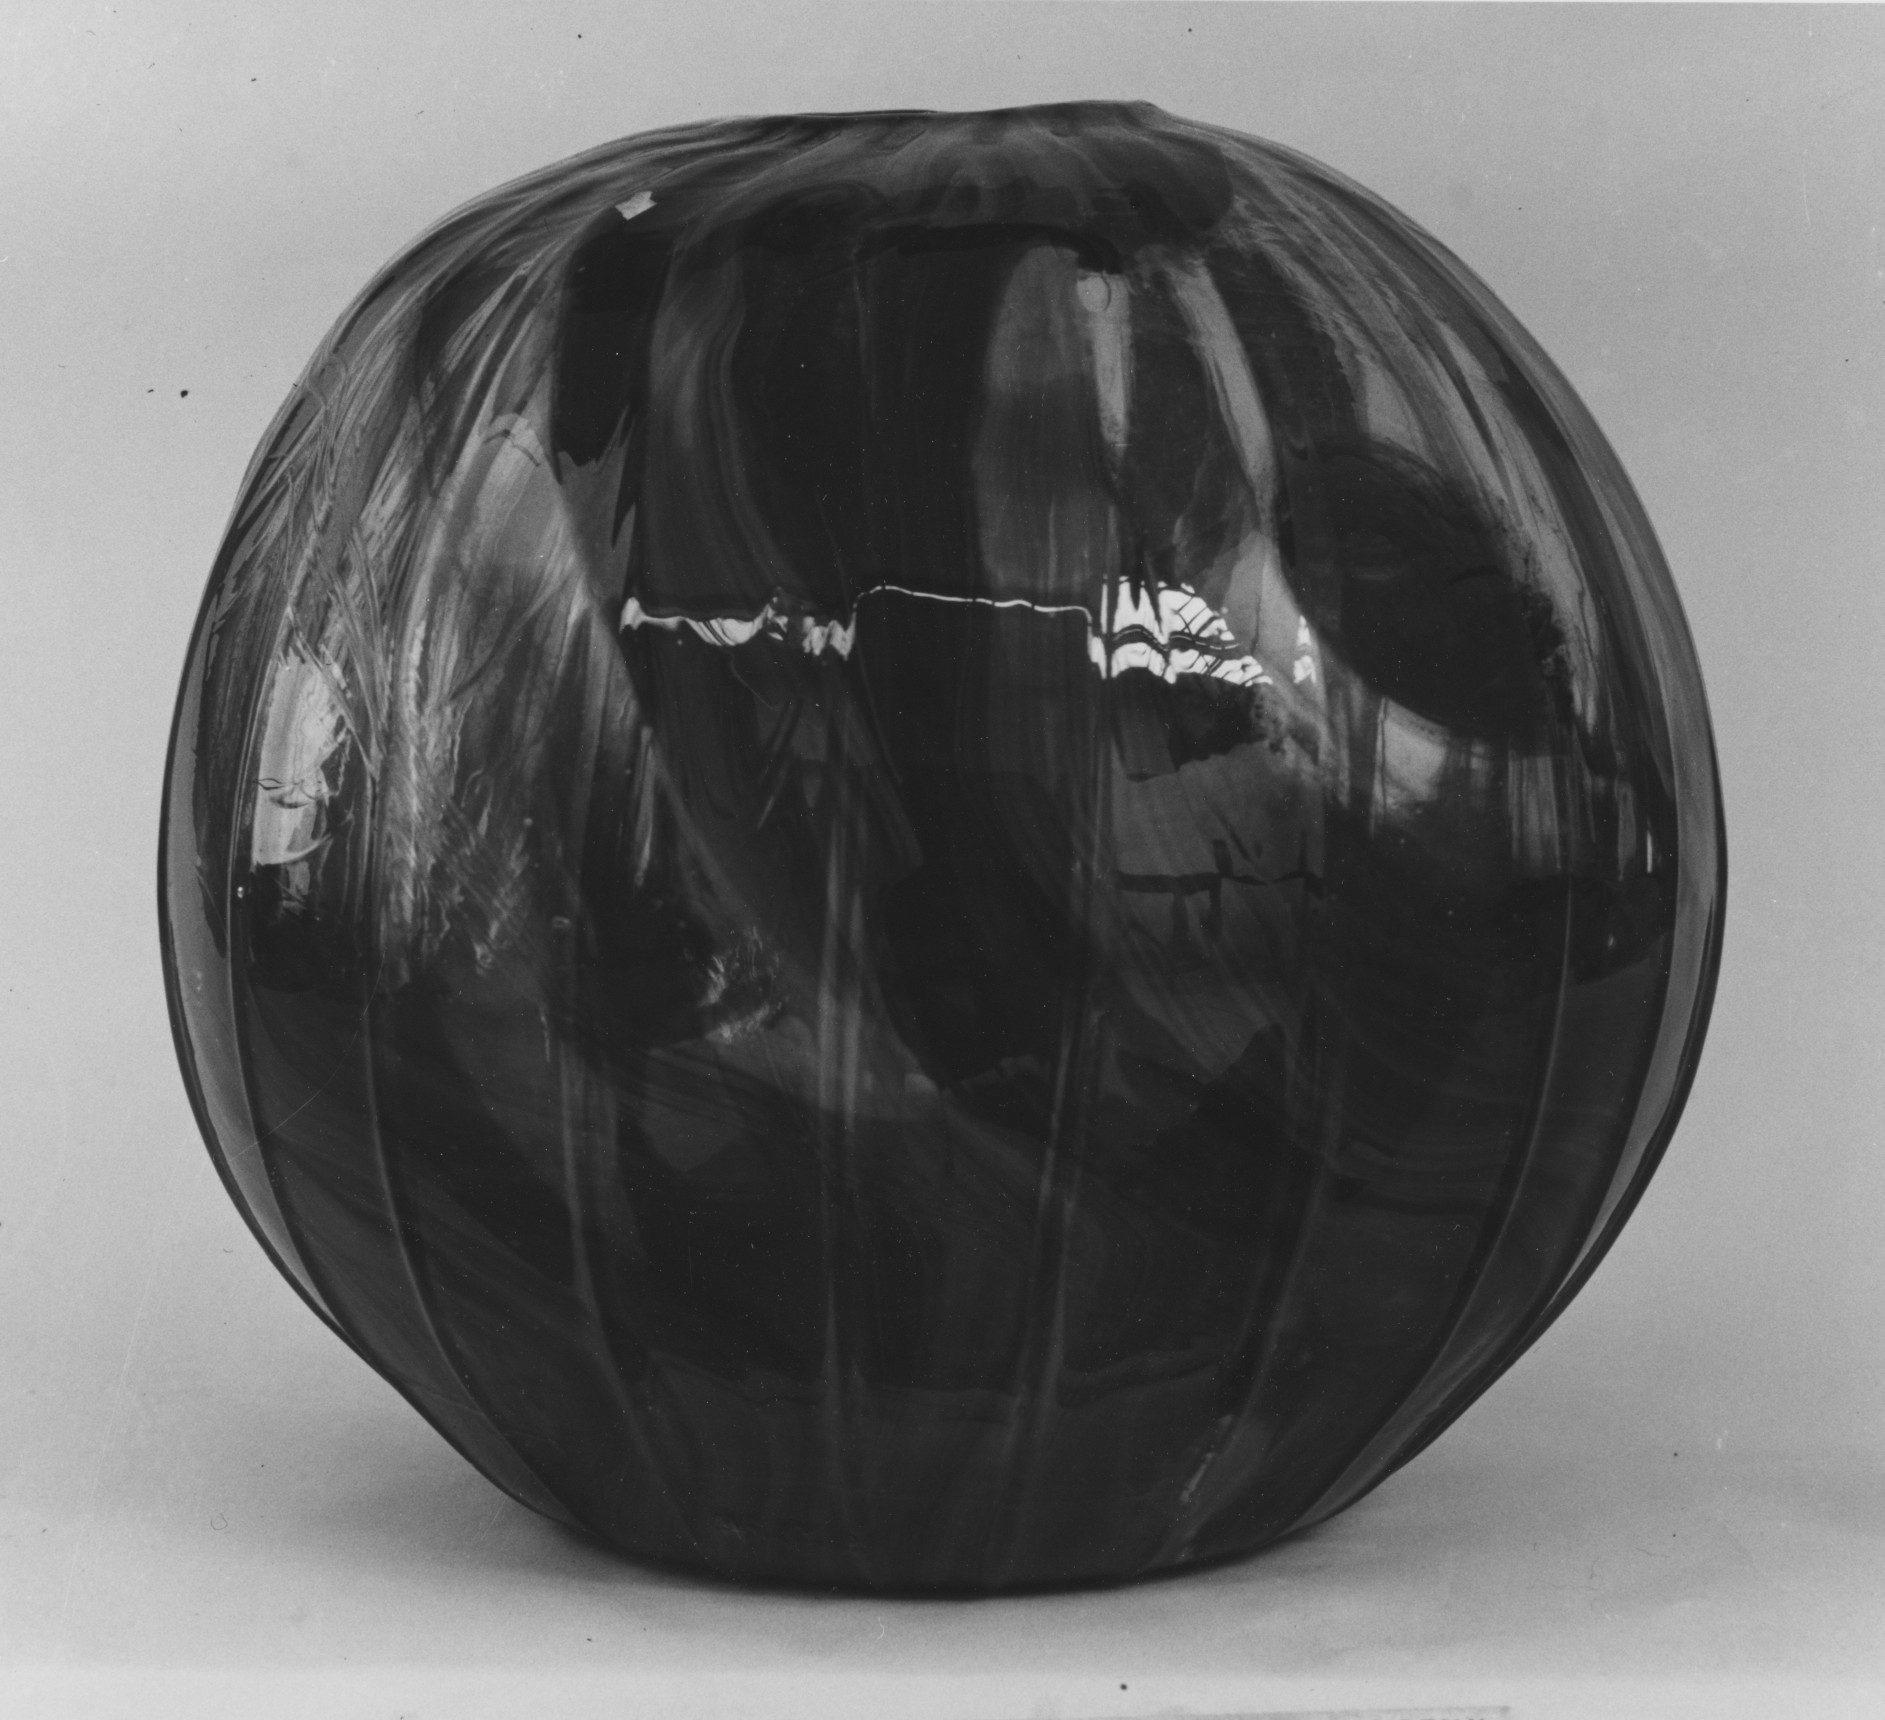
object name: bowl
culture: american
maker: louis c. tiffany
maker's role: designer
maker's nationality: american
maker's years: 1848-1933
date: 1893-1896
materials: glass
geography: united states